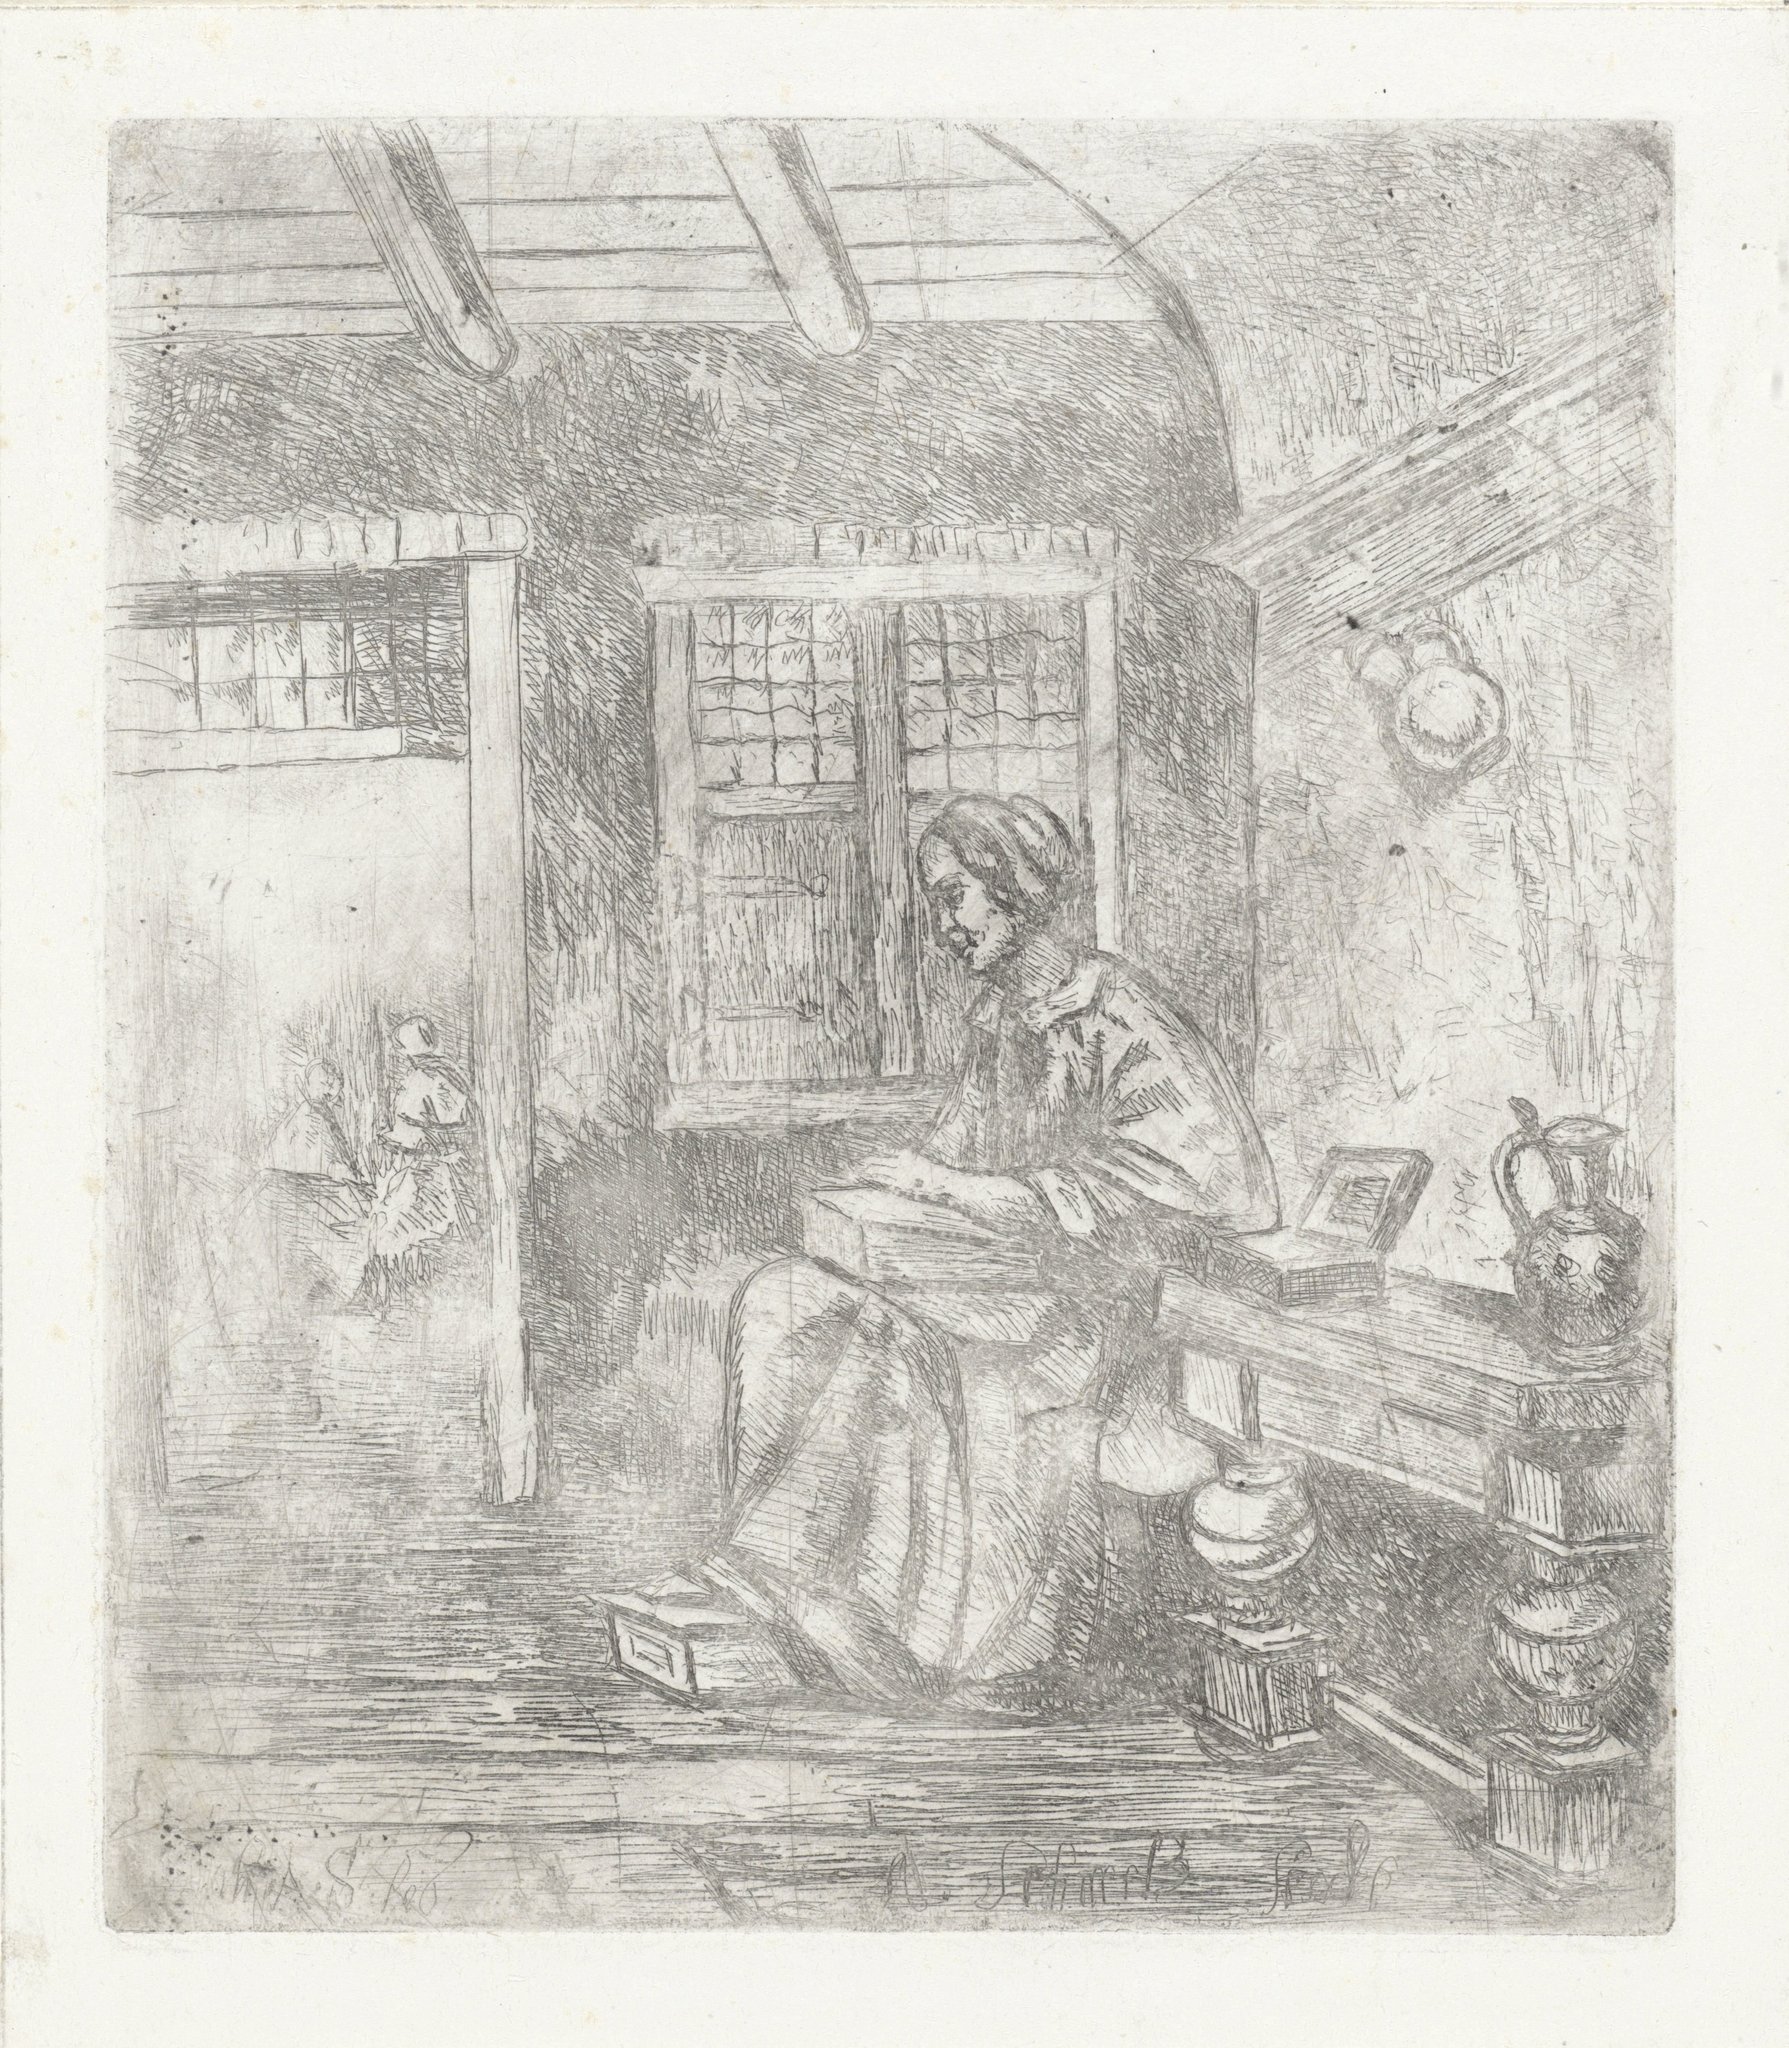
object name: print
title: Kantwerkster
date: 1830-1863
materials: paper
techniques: etching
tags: sitting figure - aa - female human figure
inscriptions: collector's mark: Lugt 2228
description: In een interieur is een vrouw aan het handwerken. Ze zit met haar voeten op een stoof. Naast haar een tafel.